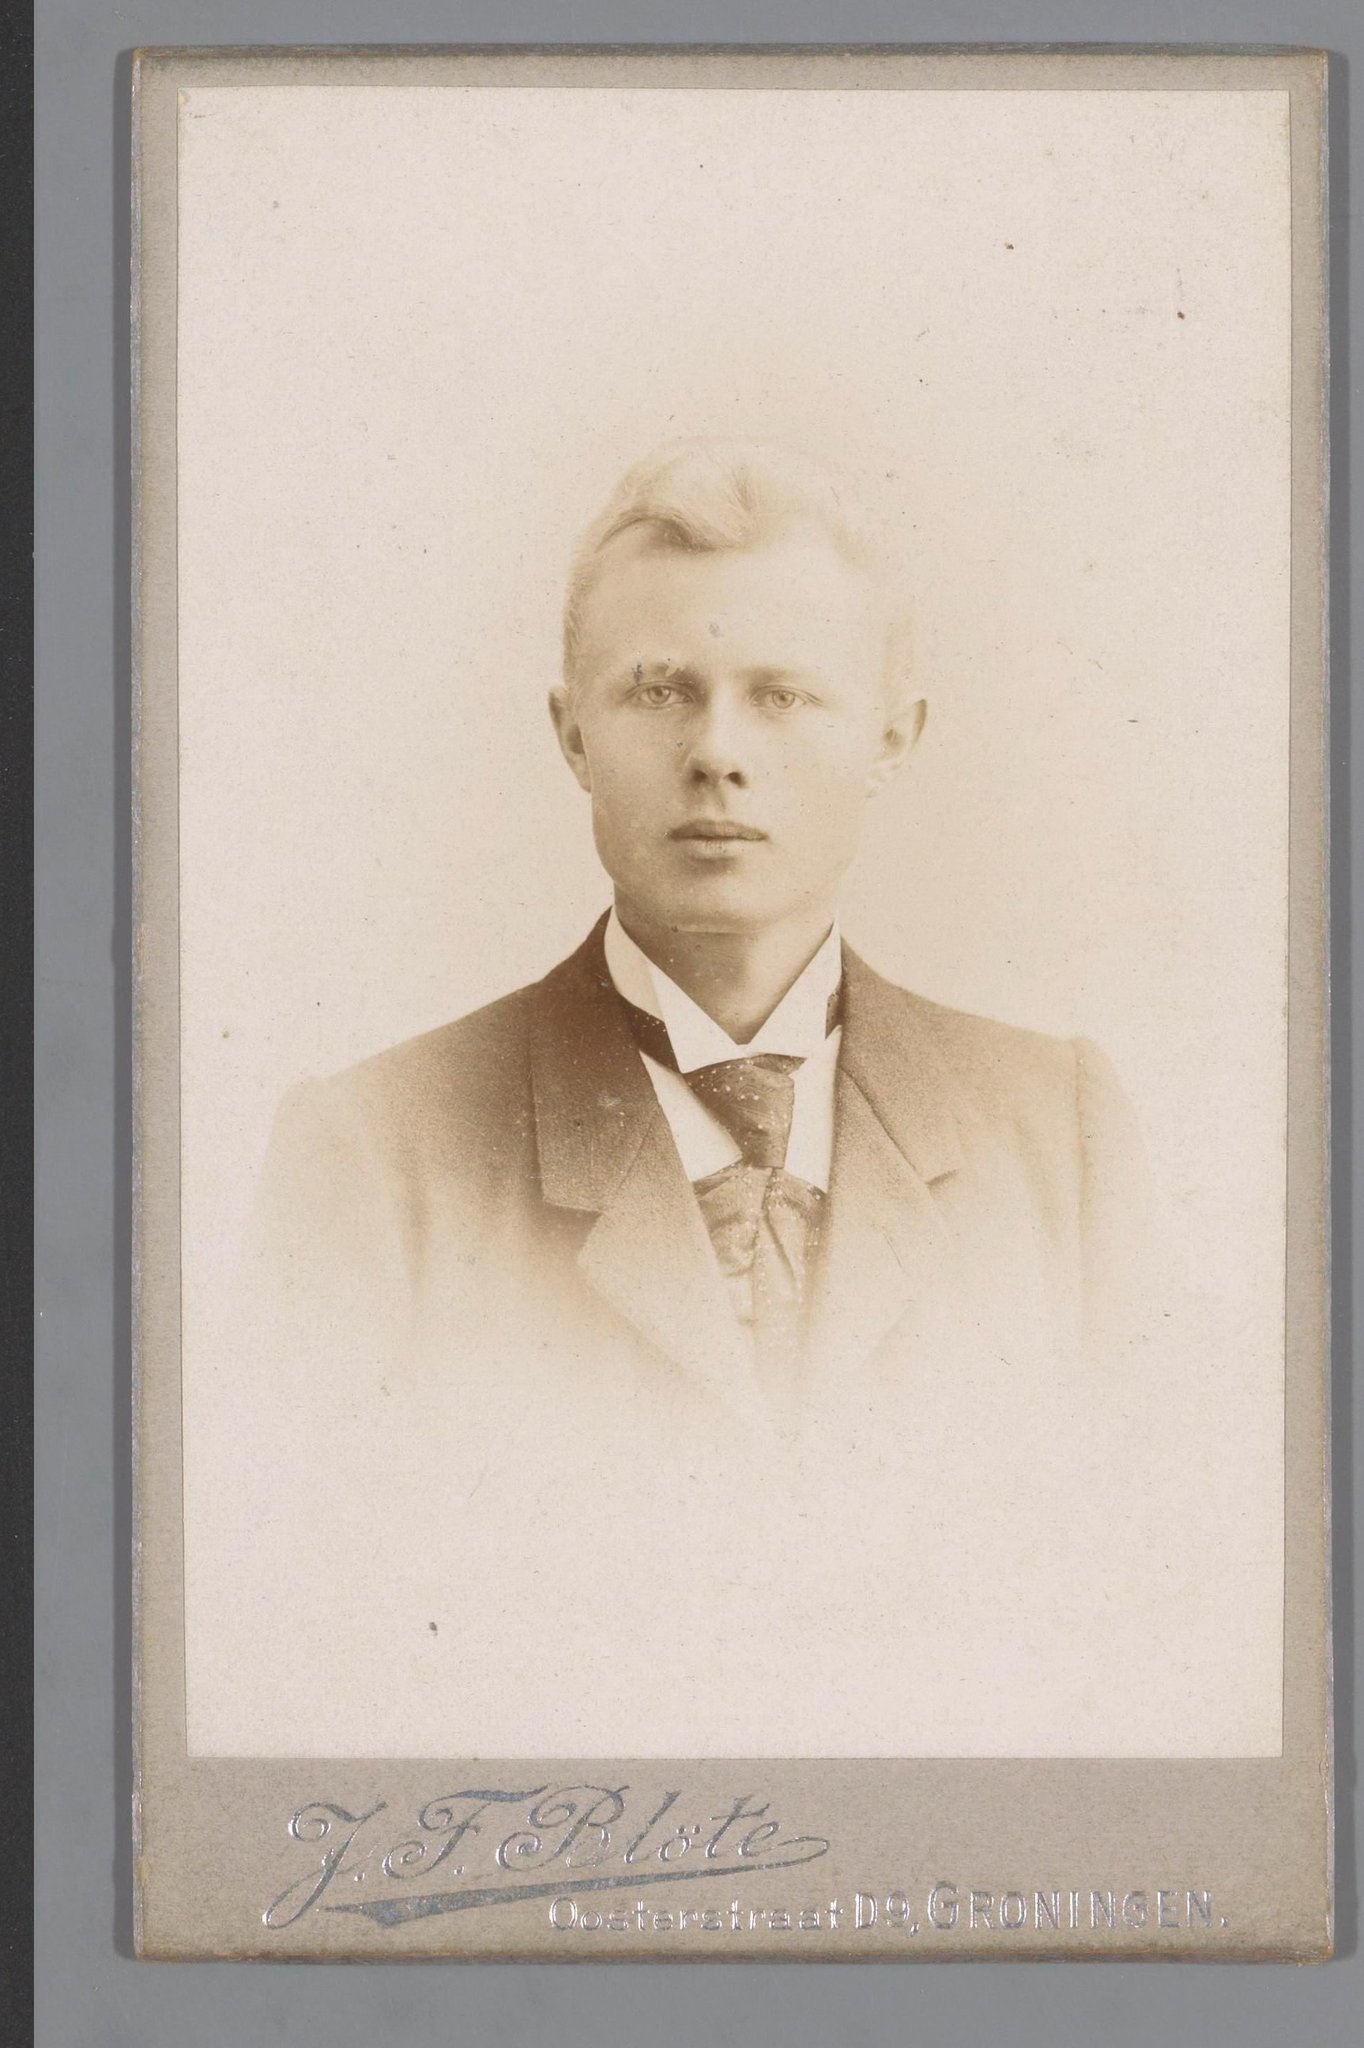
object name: carte de visite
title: Portret van een onbekende man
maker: jan frederik blöte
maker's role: fotograaf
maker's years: 1865-1956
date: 1890-1896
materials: cardboard, paper, photographic support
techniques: daylight paper print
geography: groningen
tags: adult man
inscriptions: name: ‘J.F. Blöte Oosterstraat D9, Groningen.’